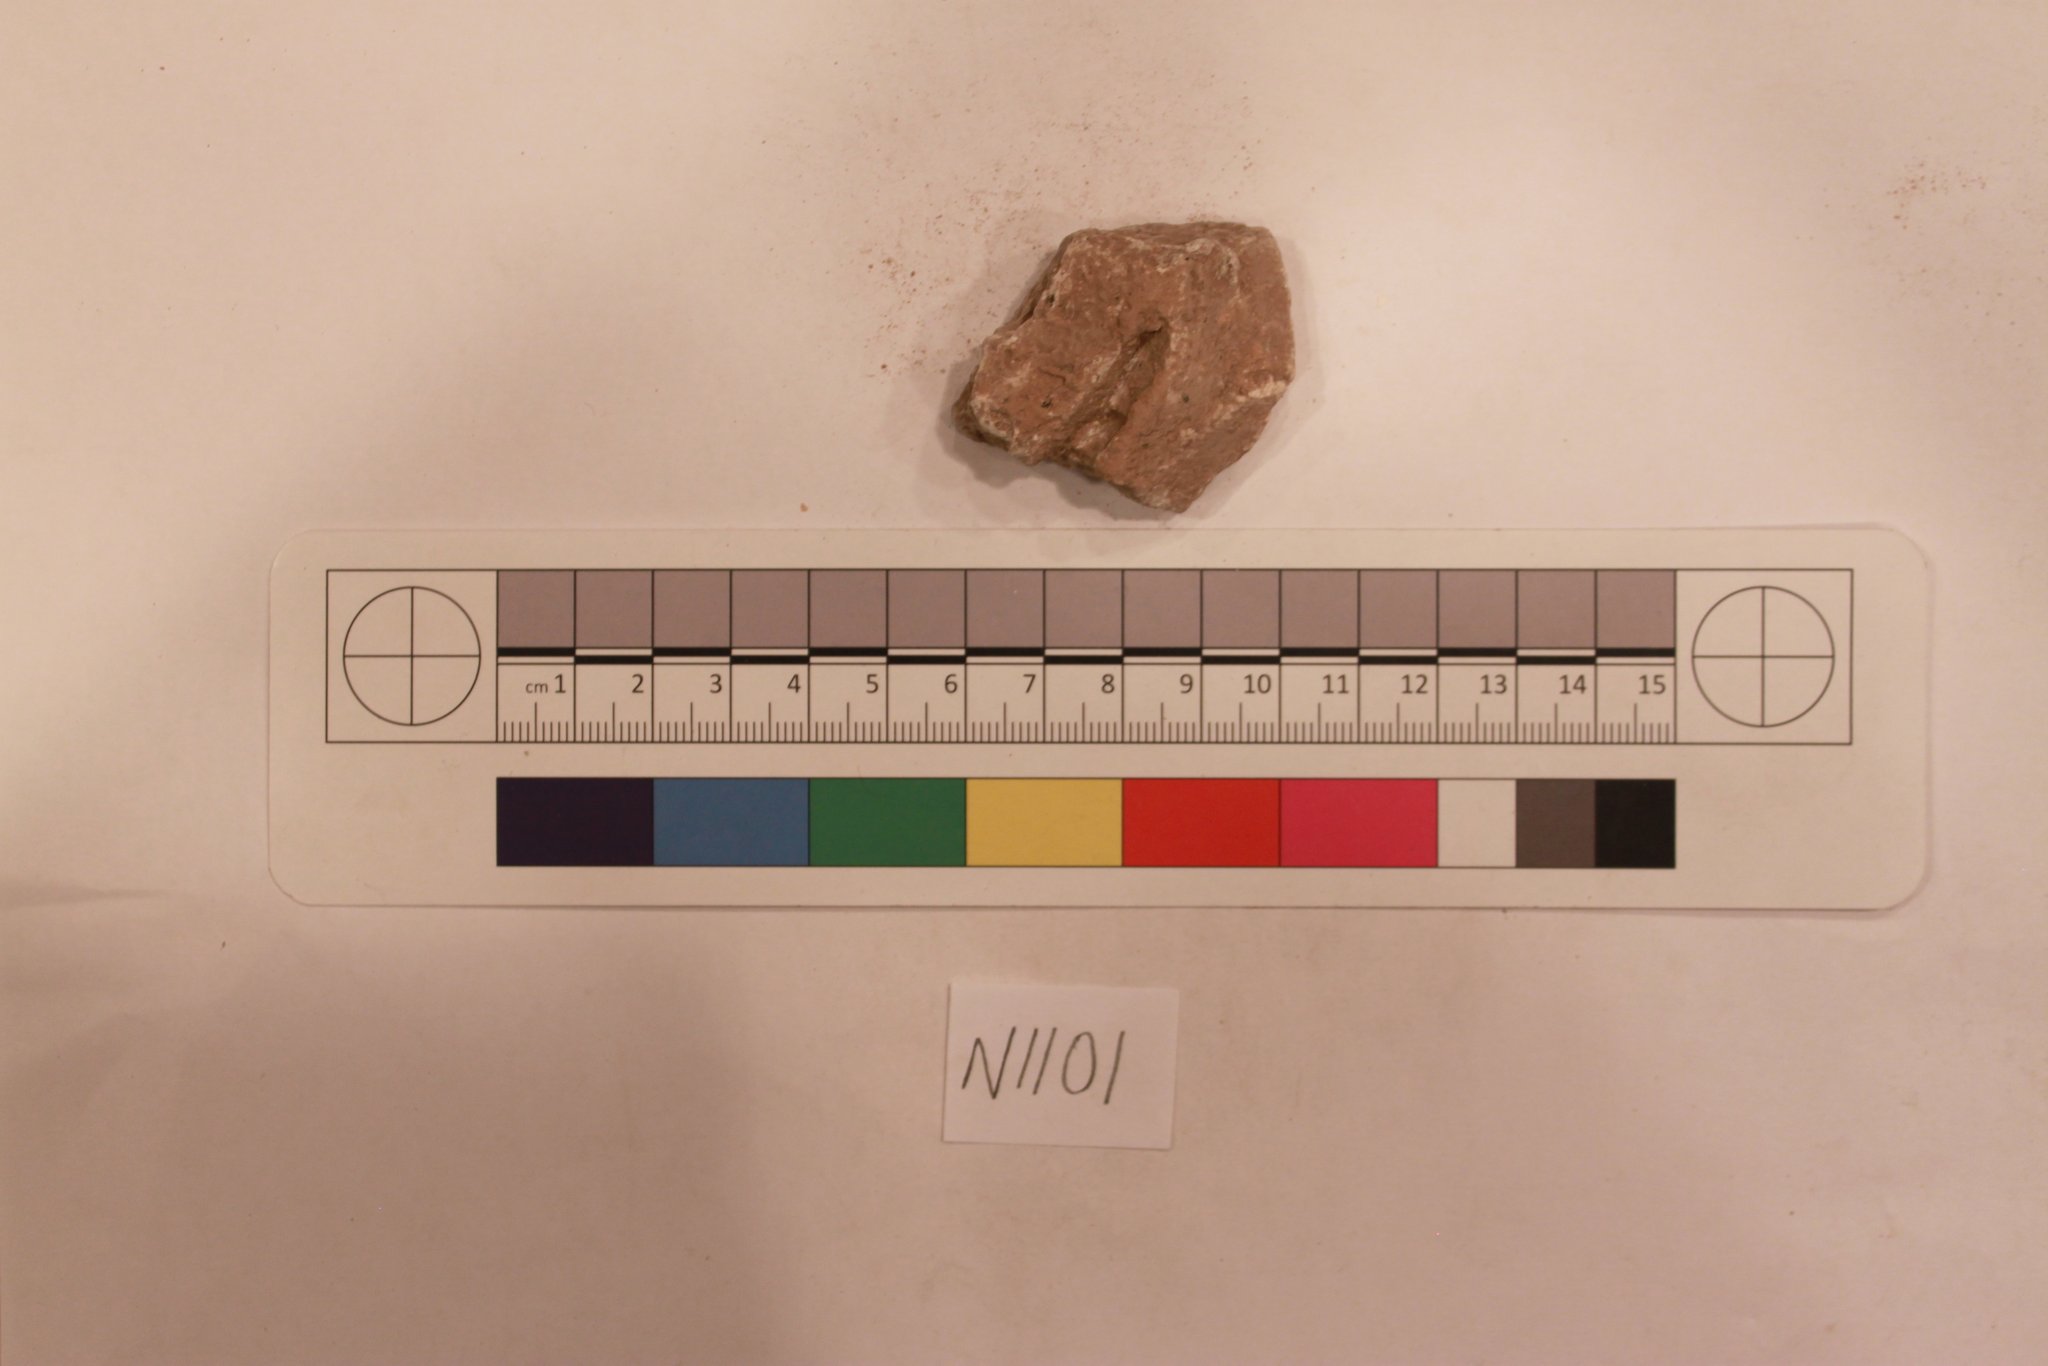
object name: fragment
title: Stucco Fragment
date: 701-1200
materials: plaster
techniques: carving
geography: iran